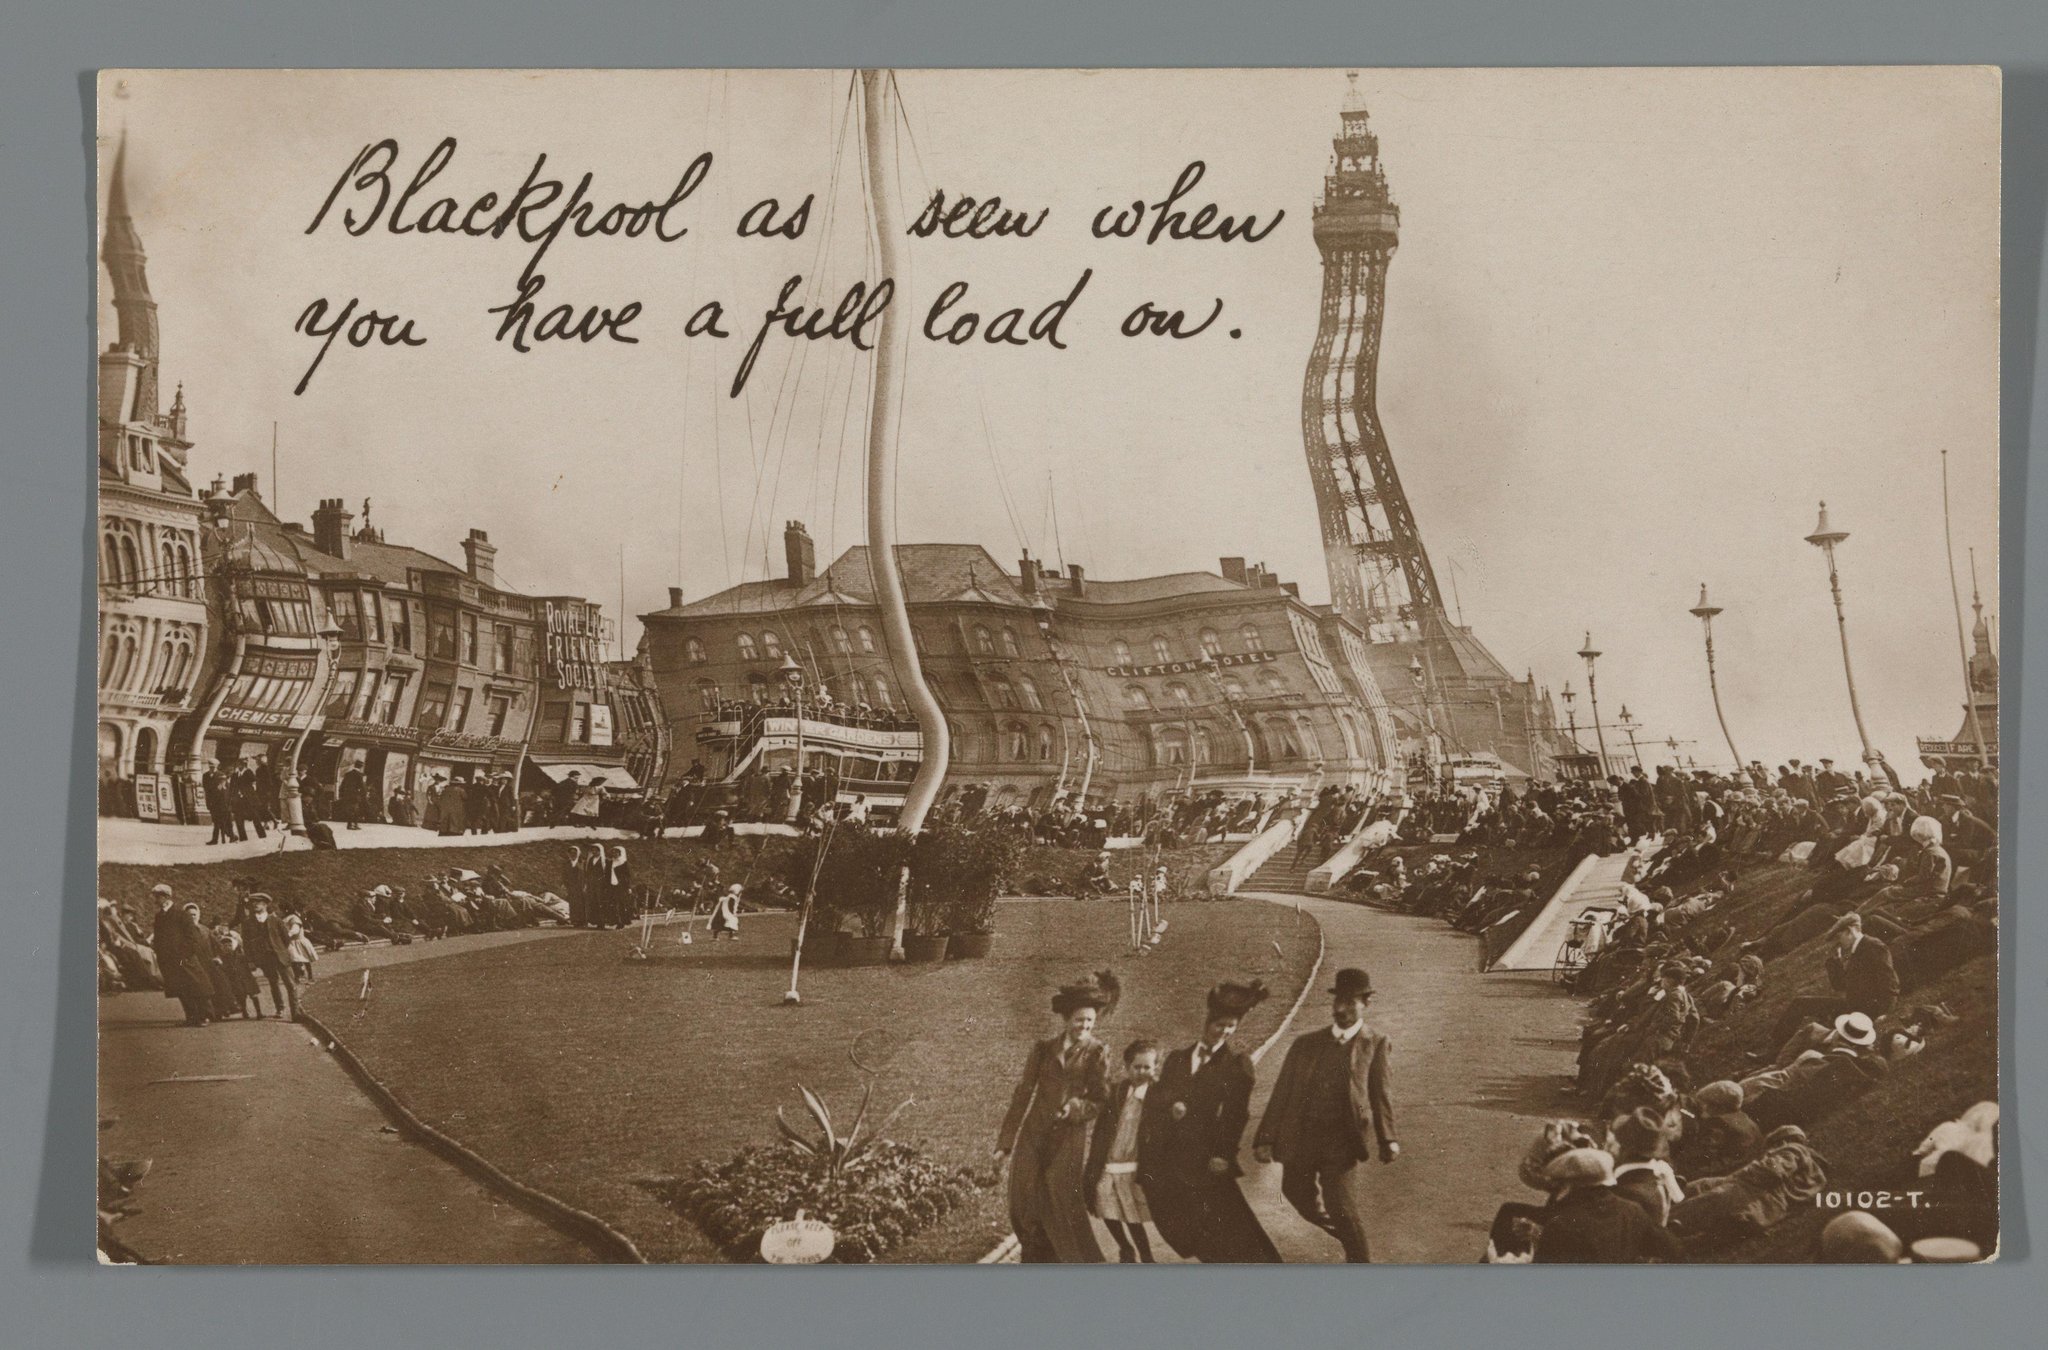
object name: ansichtkaart, prentbriefkaart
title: Blackpool as seen when you have a full load on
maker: Anonymous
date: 1905-1920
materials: paper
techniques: writing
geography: blackpool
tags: pleasure-resort, drunkenness, avenue, boulevard, promenade, esplanade